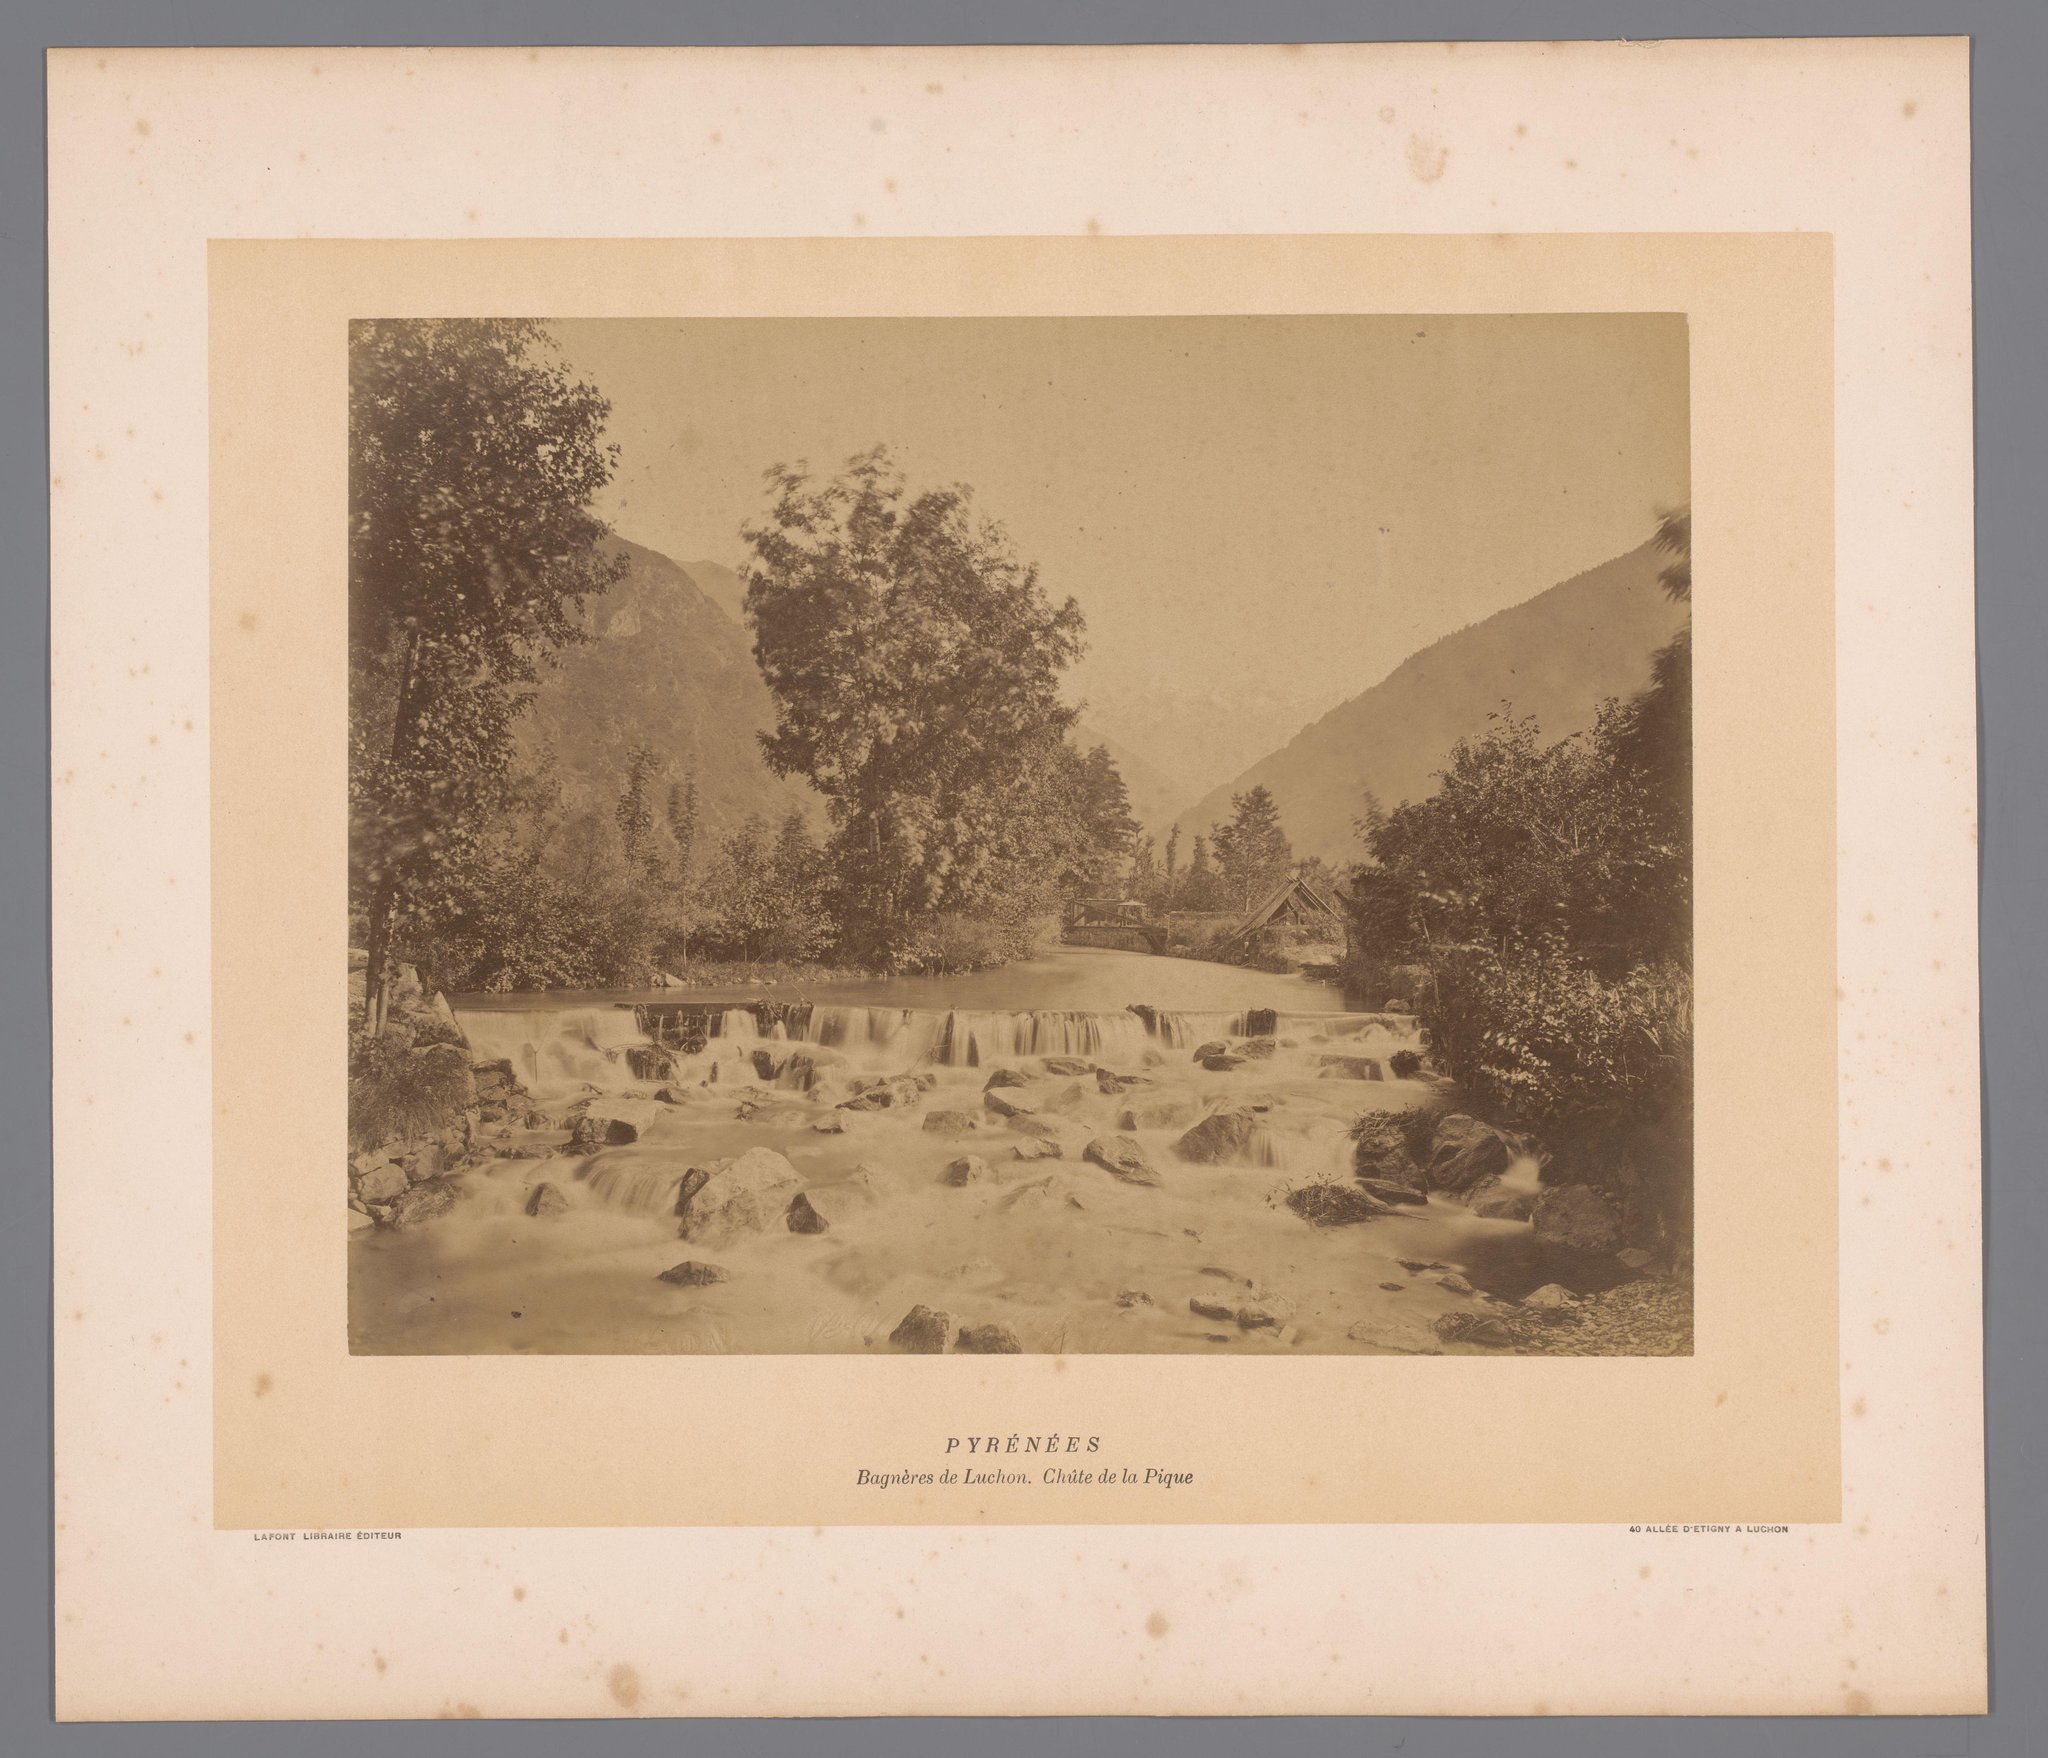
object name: photograph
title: "PYRÉNÉES//Bagnères de Luchon. Chûte de la Pique", Frankrijk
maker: Anonymous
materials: cardboard, paper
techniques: albumen print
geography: luchon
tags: pyreneeën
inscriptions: date: ‘14/16 October 1884.’, caption: ‘PYRÉNÉES//Bagnères de Luchon. Chûte de la Pique’, caption: ‘LAFONT LIBRAIRE ÉDITEUR//40 ALLÉE D'ETIGNY A LUCHON’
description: Frontaal aanzicht op een rivier met lage waterval, Frankrijk.